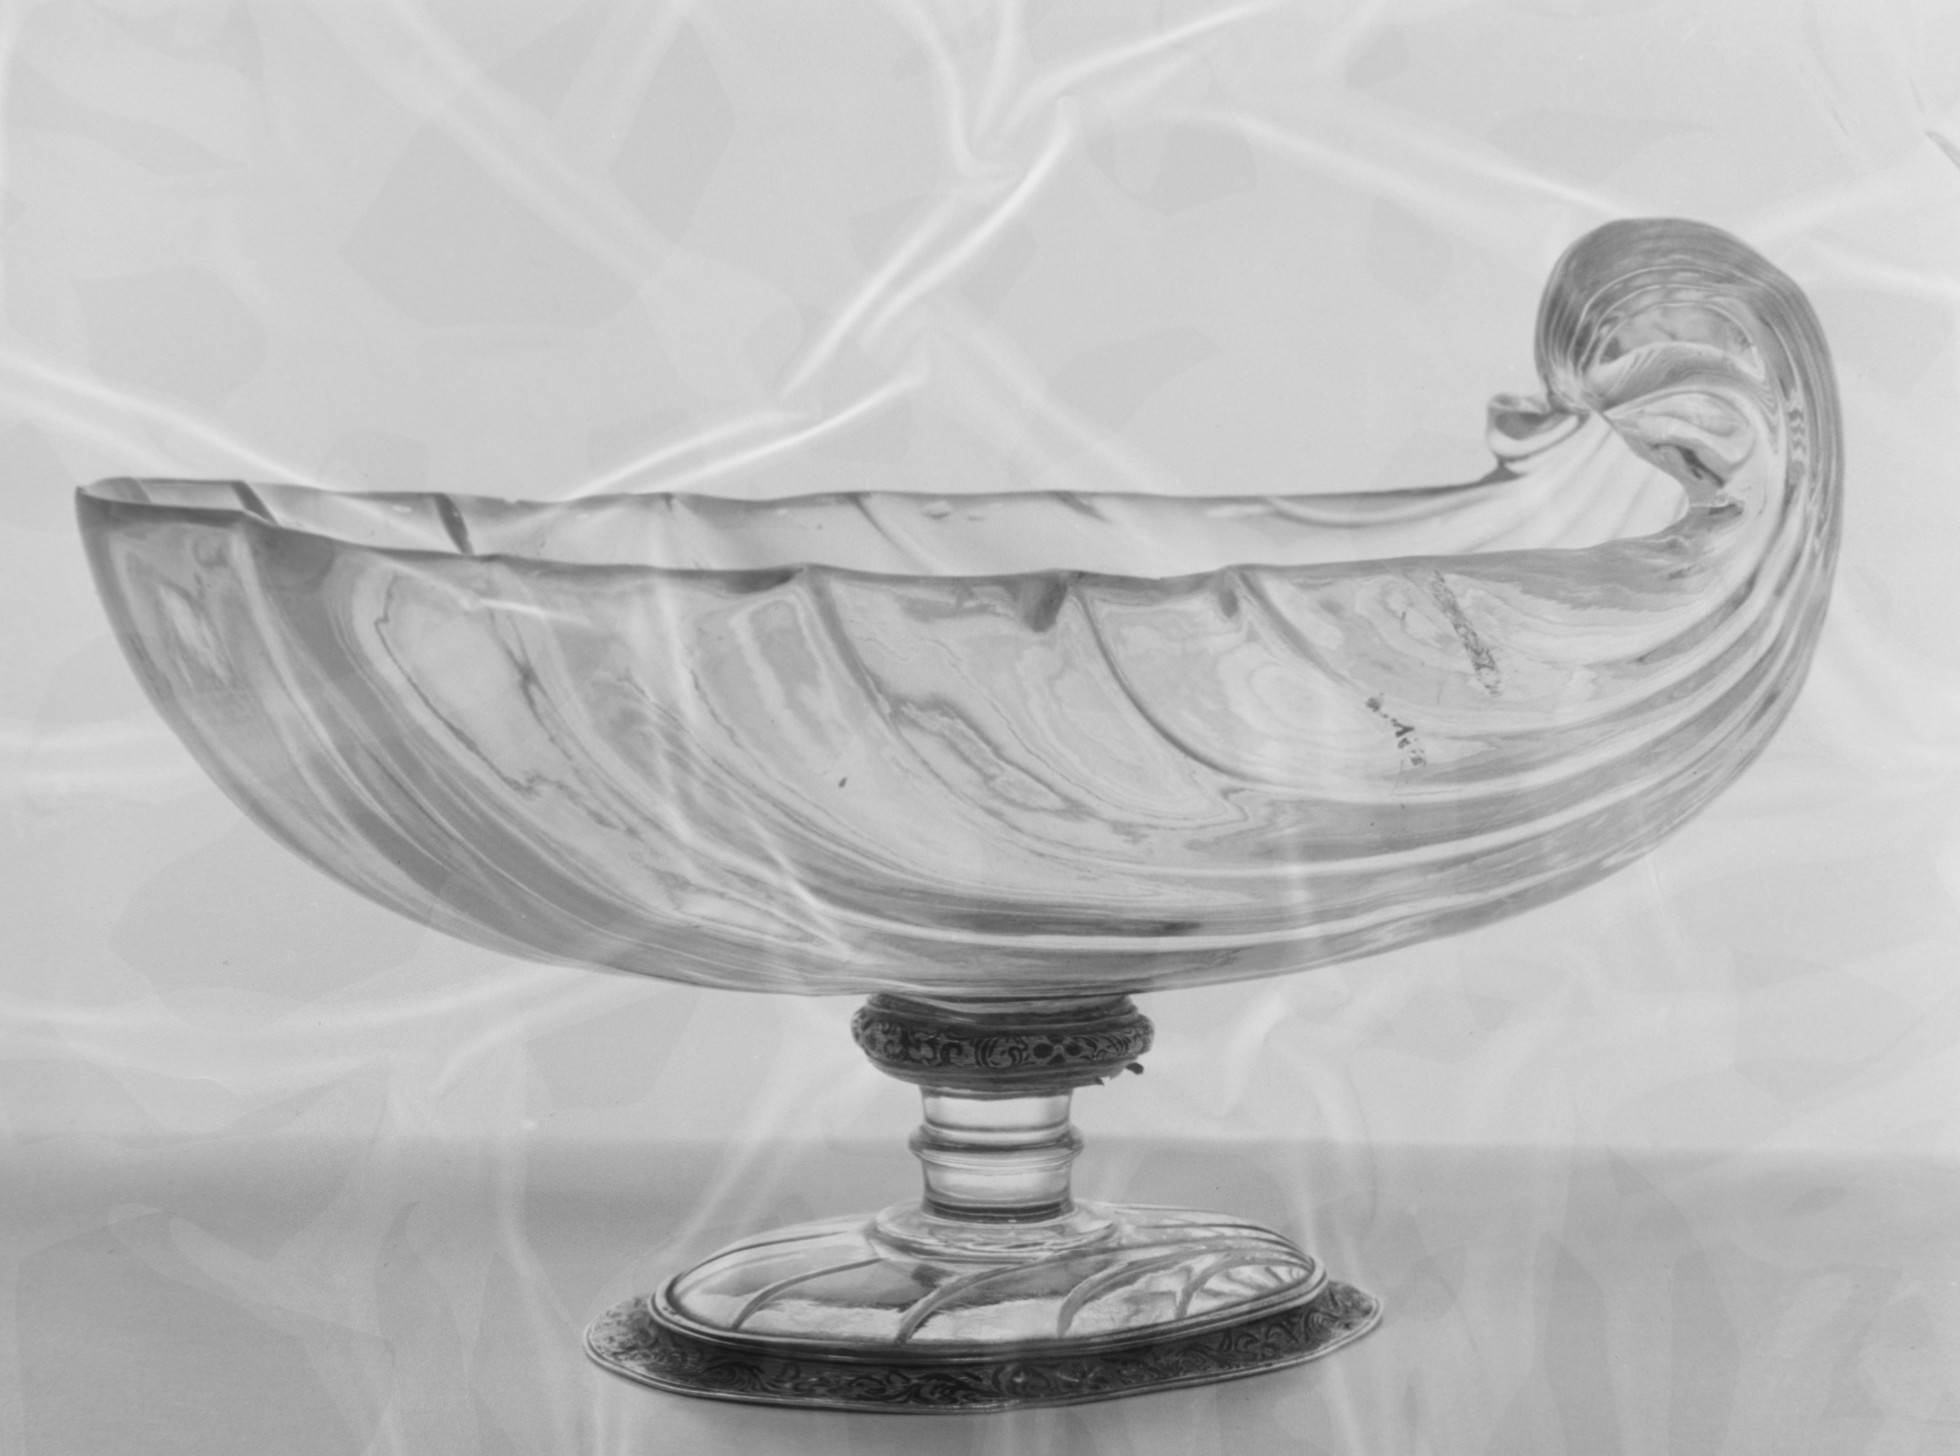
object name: standing cup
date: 1501-1600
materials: enamel, gold, quartz